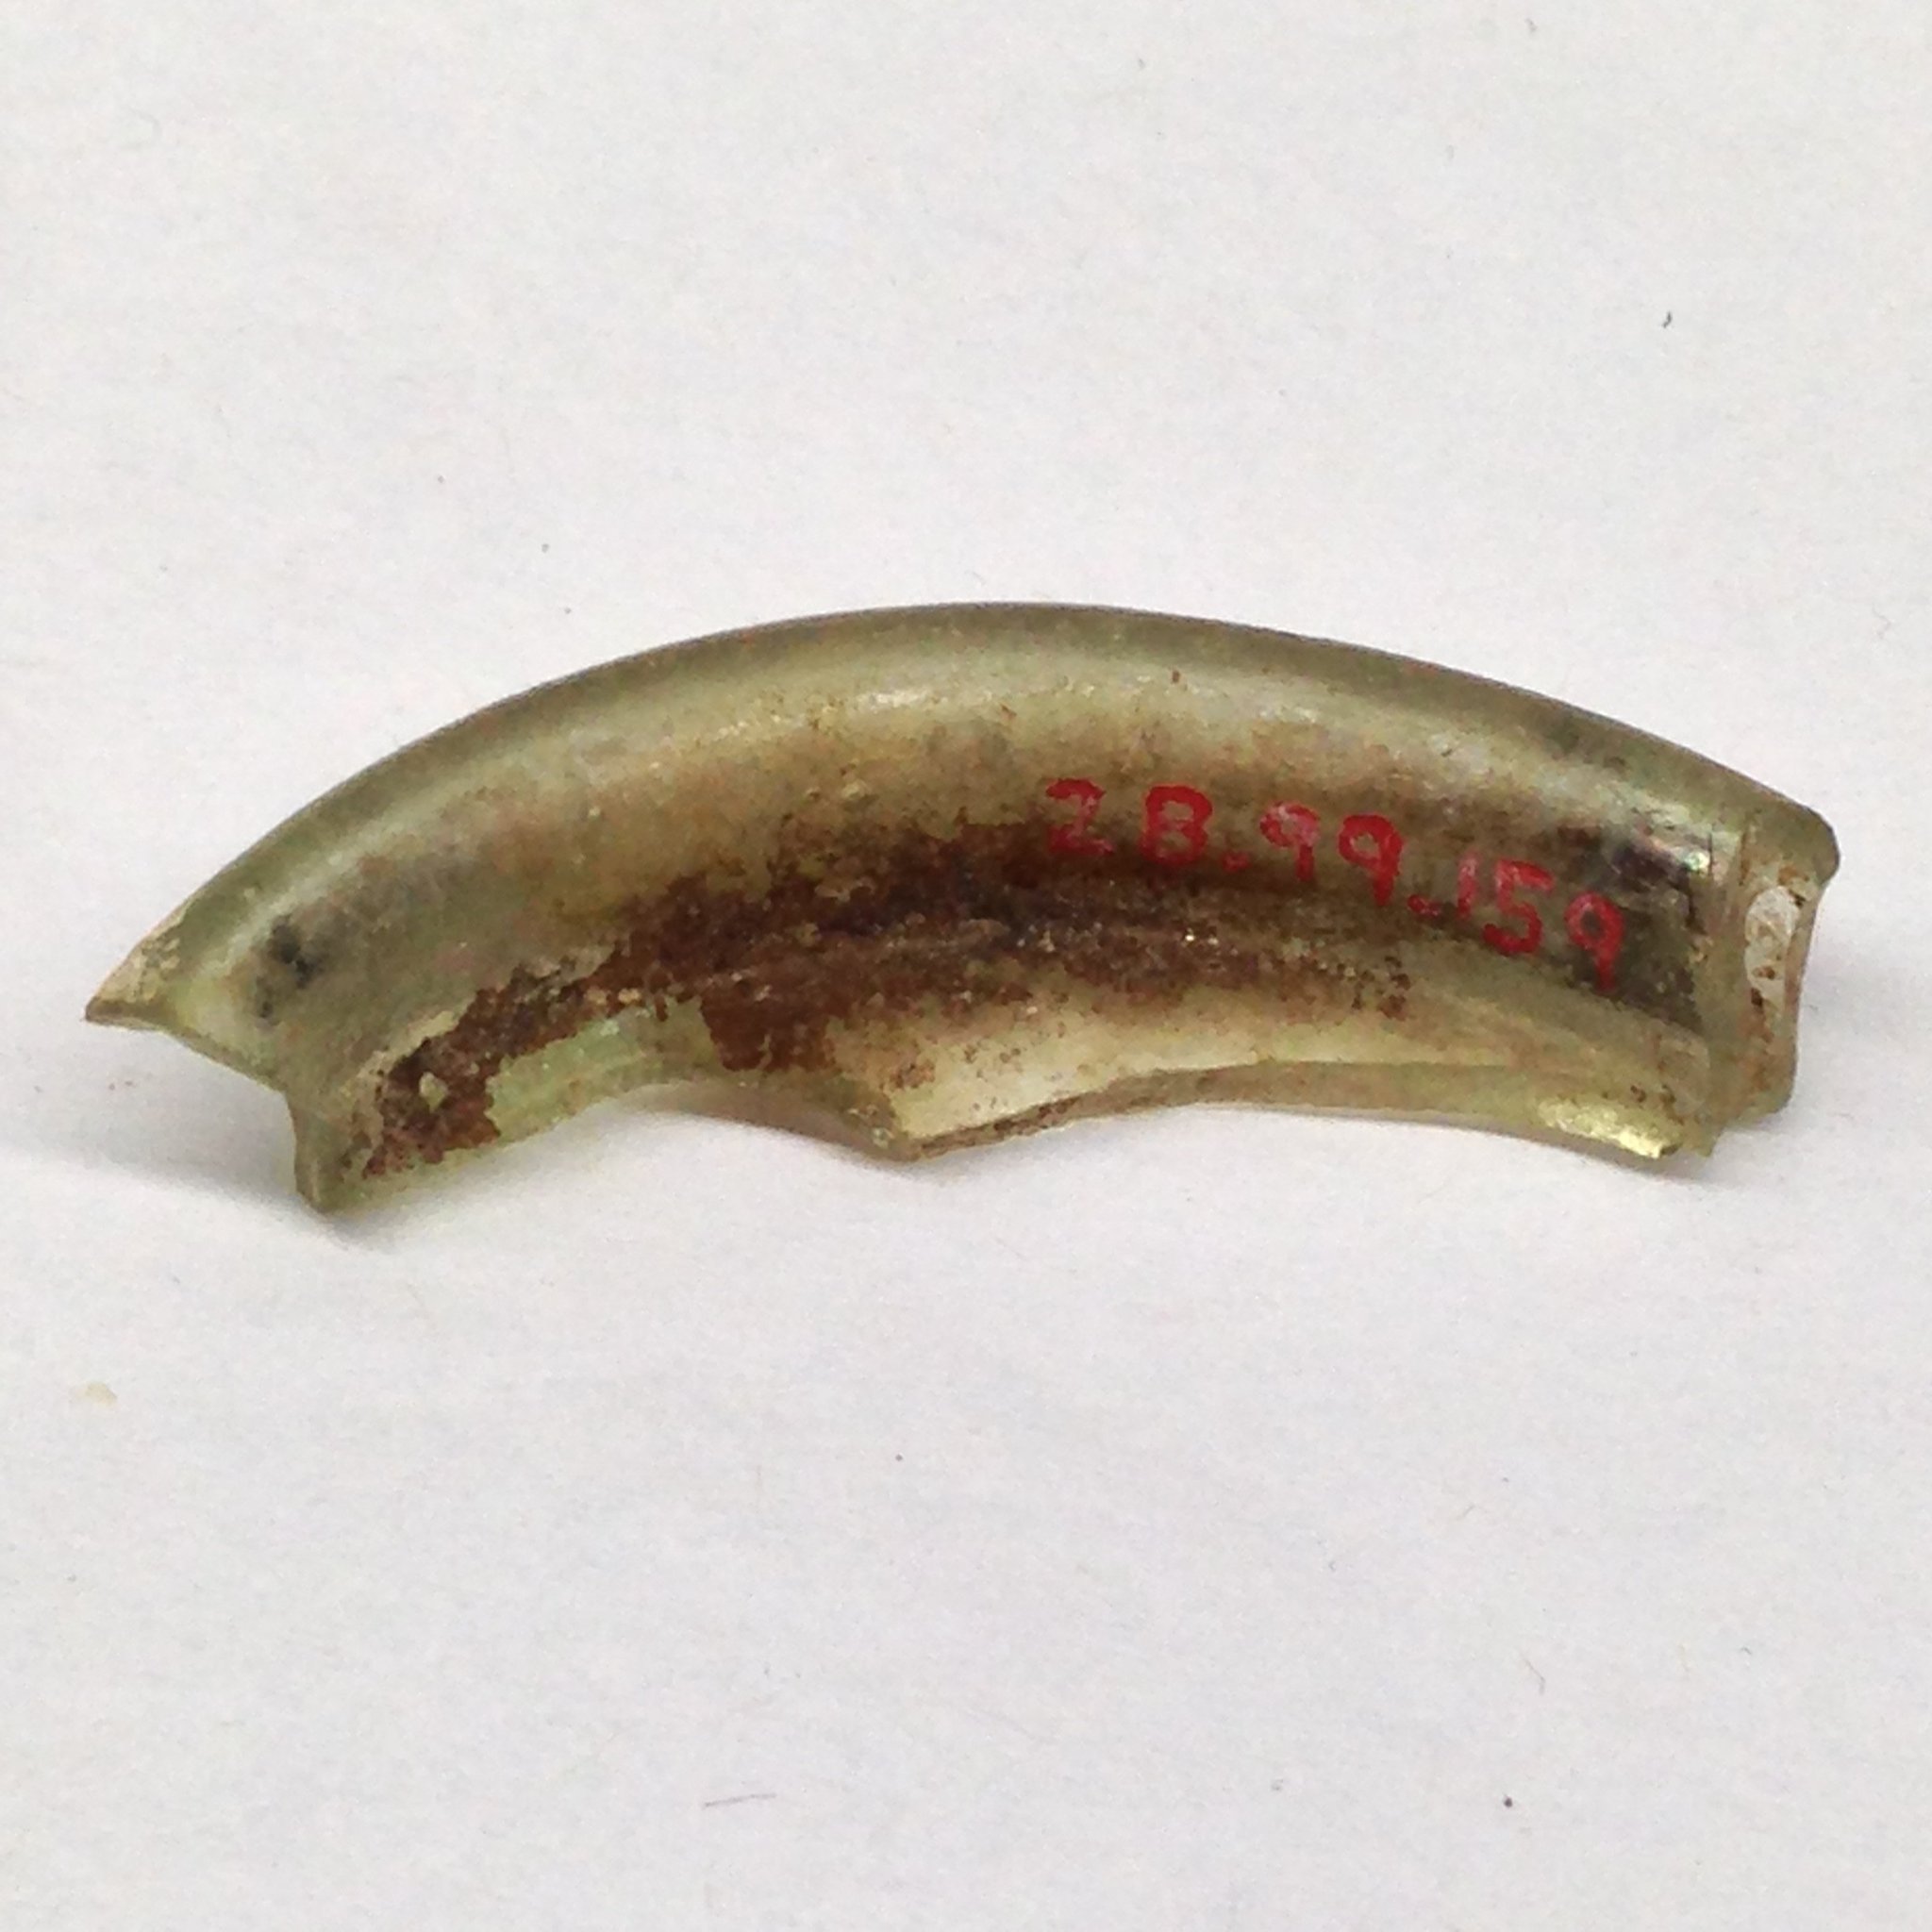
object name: fragment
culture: european or middle eastern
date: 1150-1250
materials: ceramic, glass